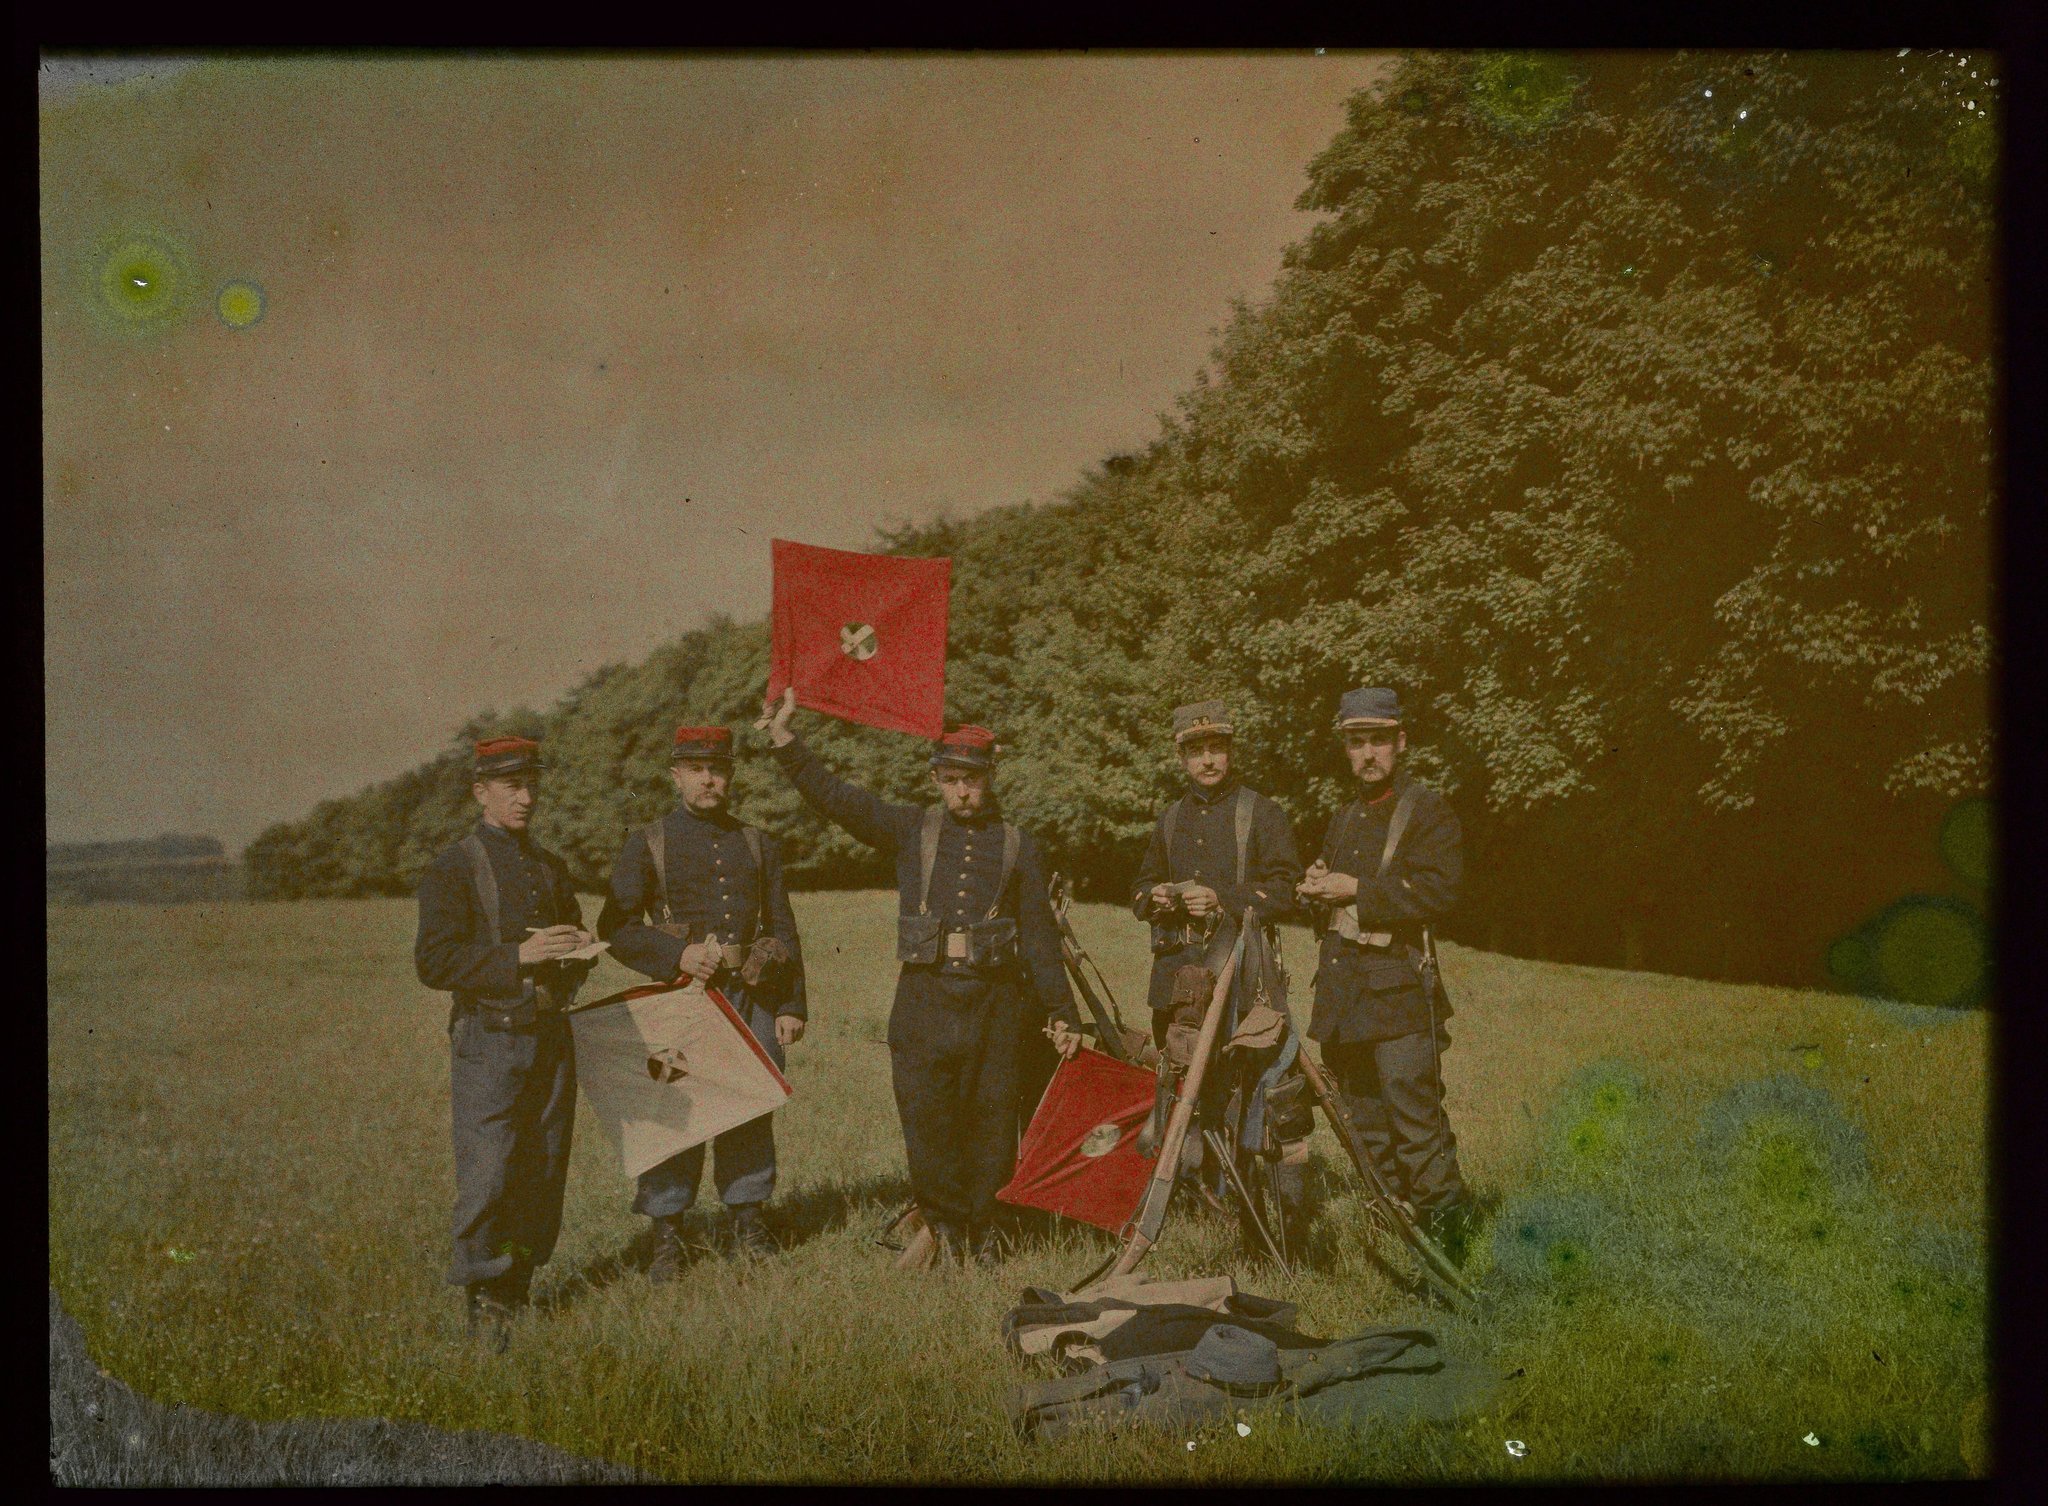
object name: glasdia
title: Franse infanteristen met seinvlaggen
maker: Anonymous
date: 1907-1935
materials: glass, paper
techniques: autochrome process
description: Groepsportret van vijf Franse infanteristen met rode en witte seinvlaggen.